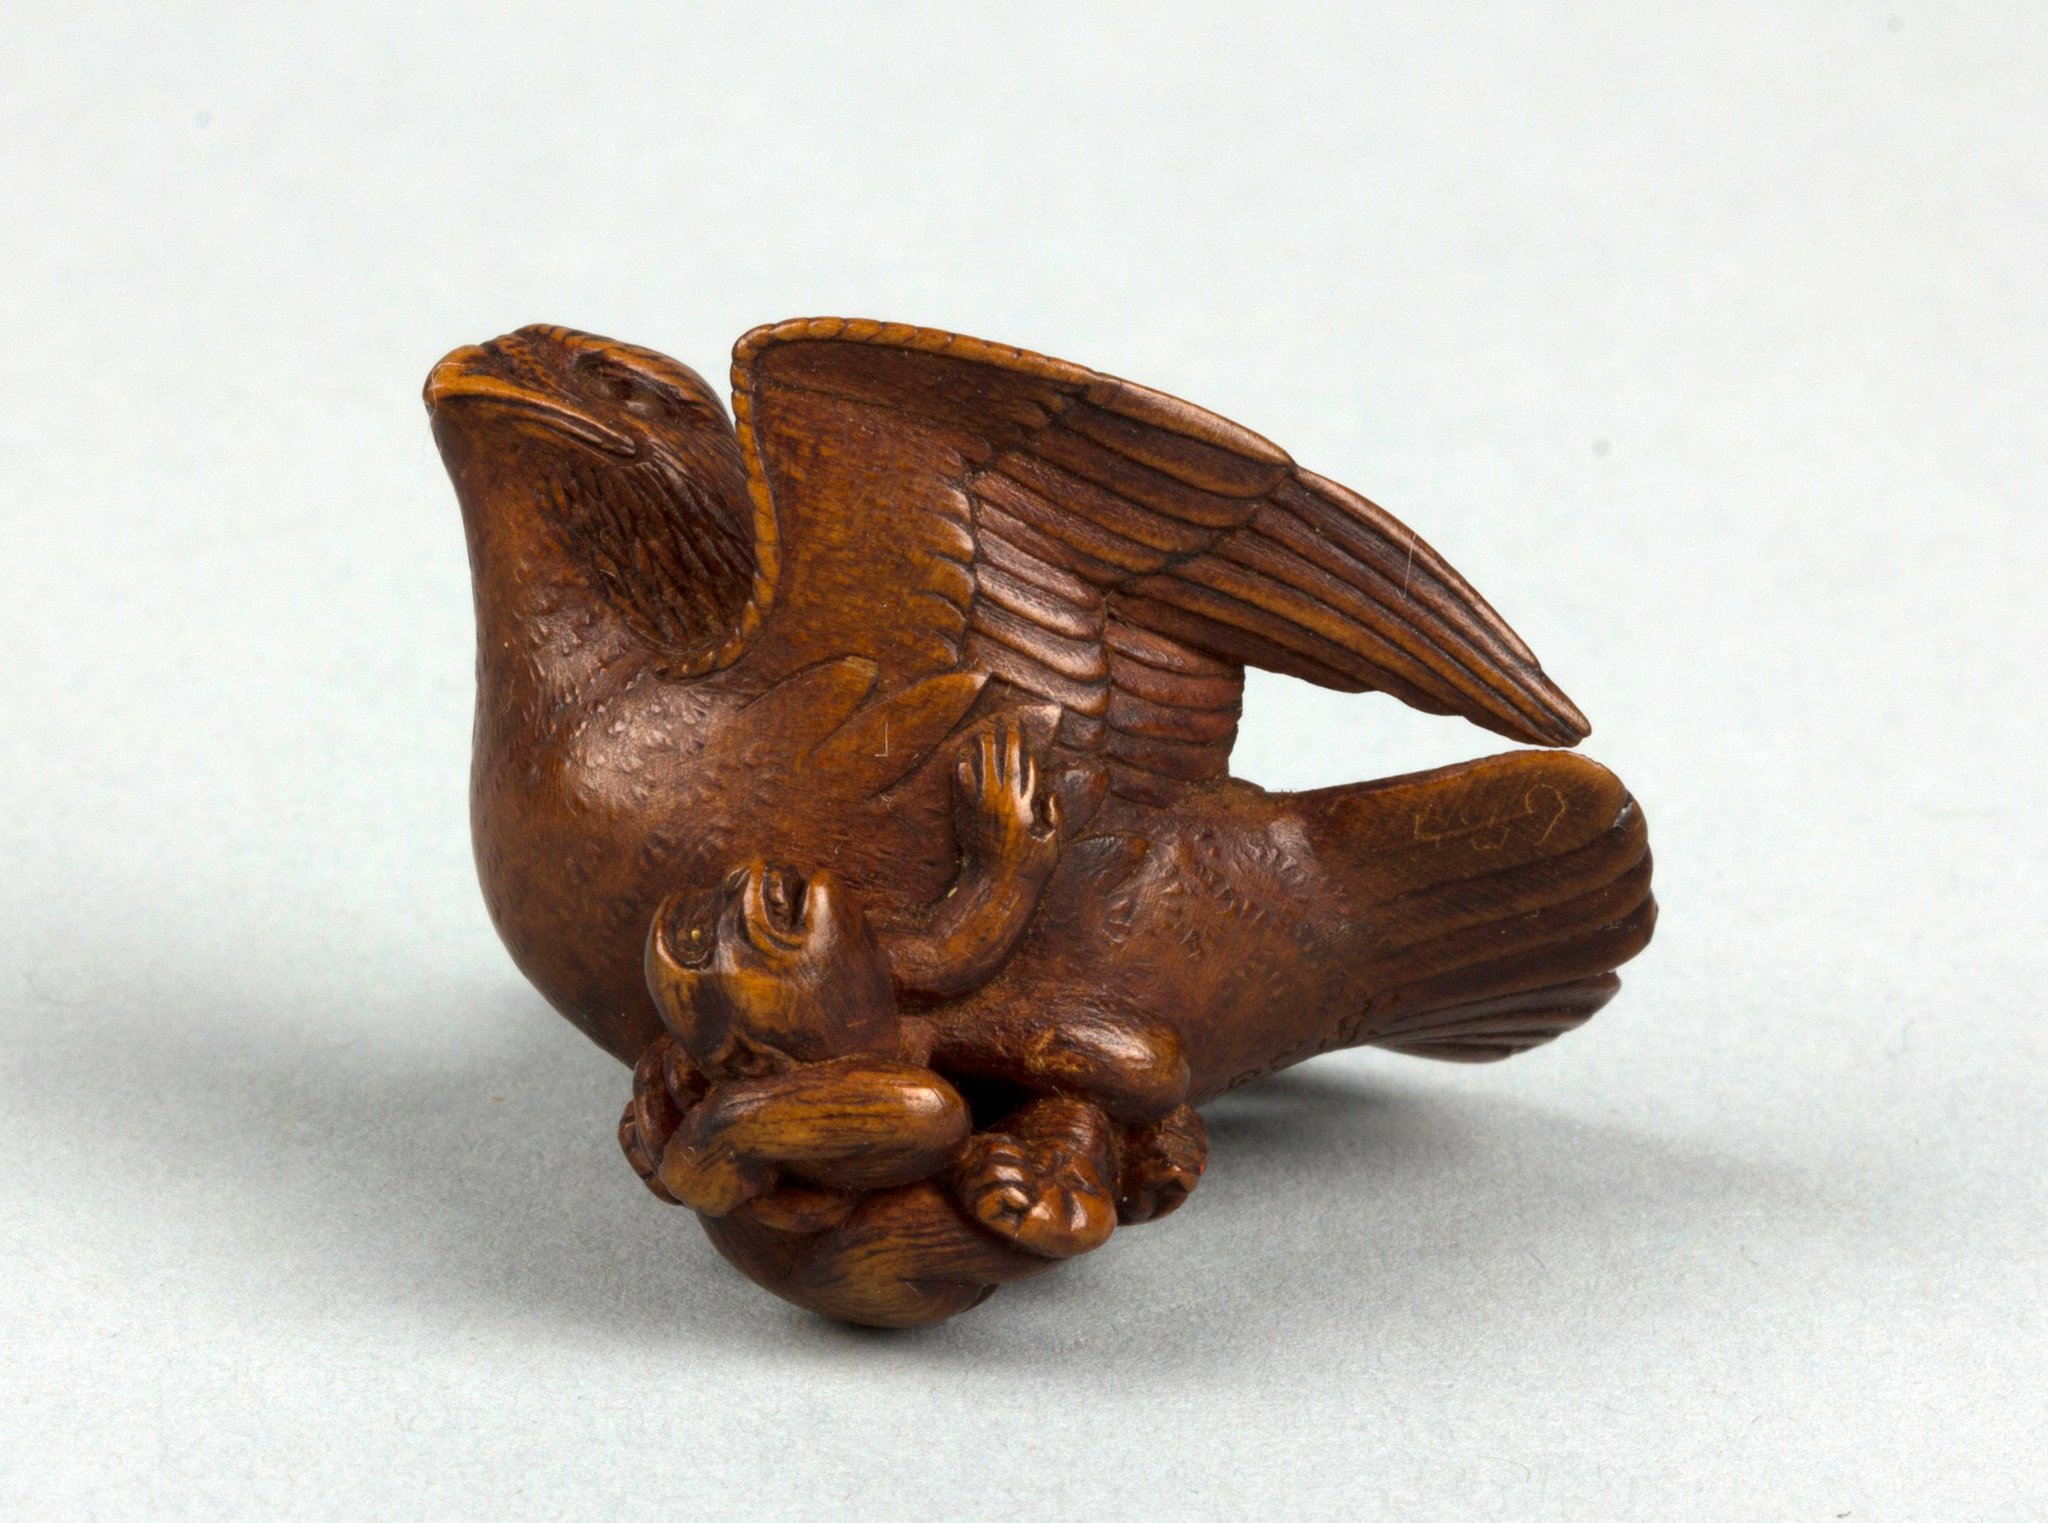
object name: netsuke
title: Netuske of Eagle Carrying Away a Small Monkey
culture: japanese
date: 1801-1900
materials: wood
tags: eagles,monkeys